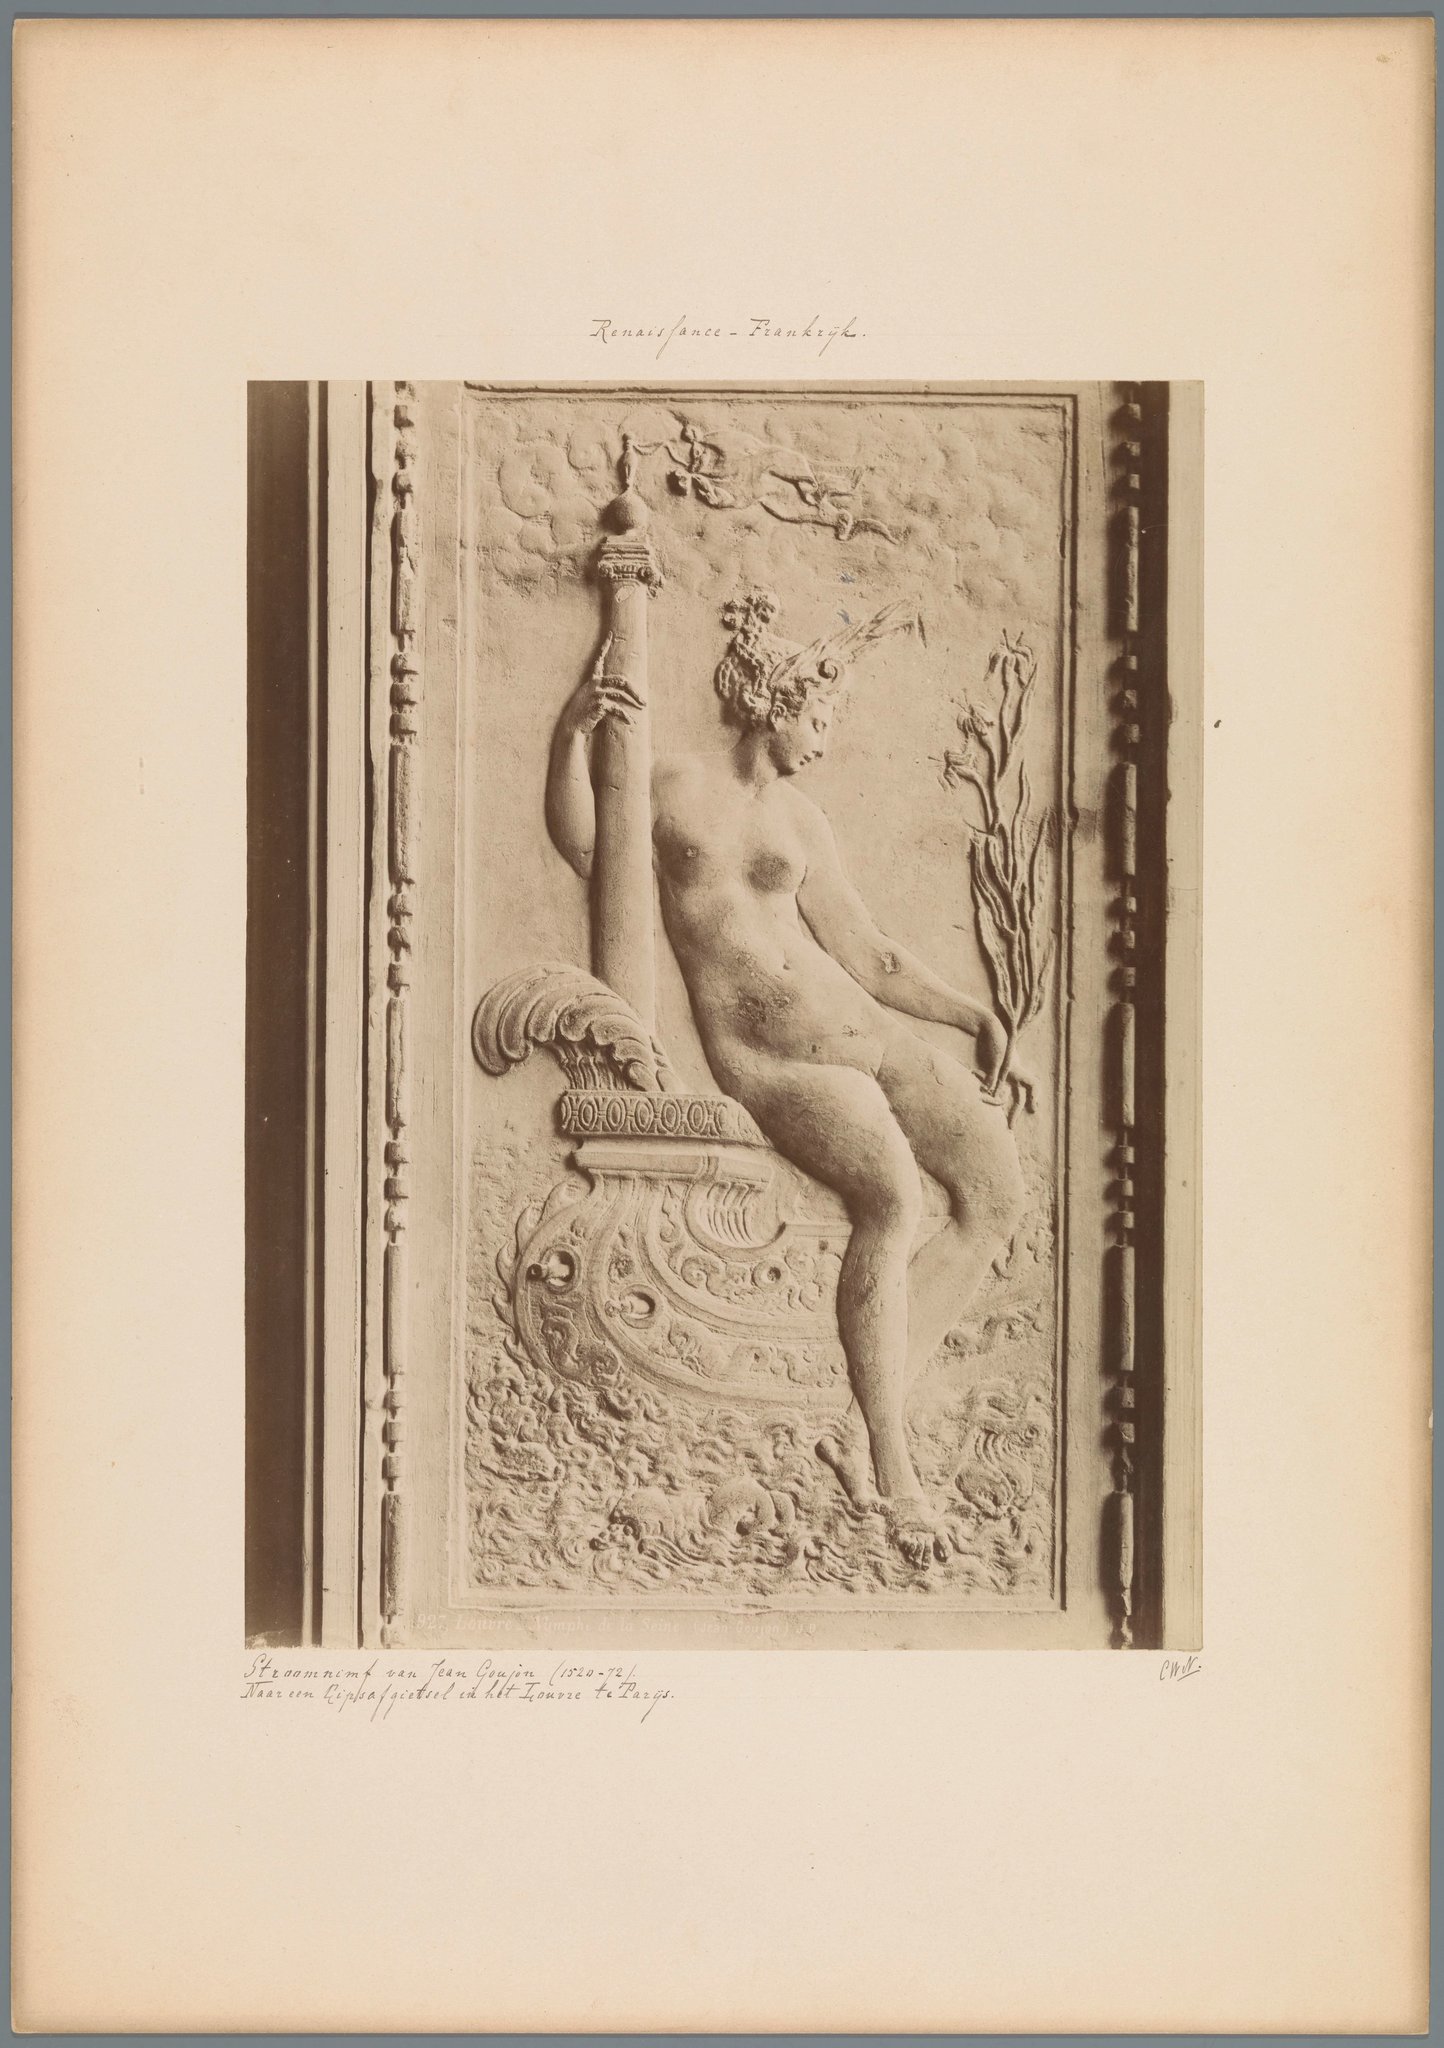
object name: photograph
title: Gipsafgietsel van een reliëf van de waternimf van de Seine in het Musée du Louvre te Parijs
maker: Anonymous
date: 1875-1900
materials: cardboard, photographic support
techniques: albumen print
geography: louvre museum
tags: ships (in general), naiads, river- and spring-nymphs; usually carrying an urn; 'naiadi, ninfe de' fiumi' (ripa), sculpture (+ relief ~ sculpture)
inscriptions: inscription: ‘Renaissance - Frankrijk. Stroomnimf van Jean Goujon (1520-72). Naar een Gipsafgietsel in het Louvre te Parijs.’, collector's mark: ‘KUNSTNIJVERHEIDSCHOOL QUELLINUS AMSTERDAM FRANS HALSSTRAAT 14.’, inscription: ‘CWN.’, inscription: ‘J.D.’, collector's mark: ‘INSTITUUT VOOR KUNST- NIJVERHEIDSONDERWIJS GABRIËL METSUSTRAAT No. 16. AMSTERDAM’